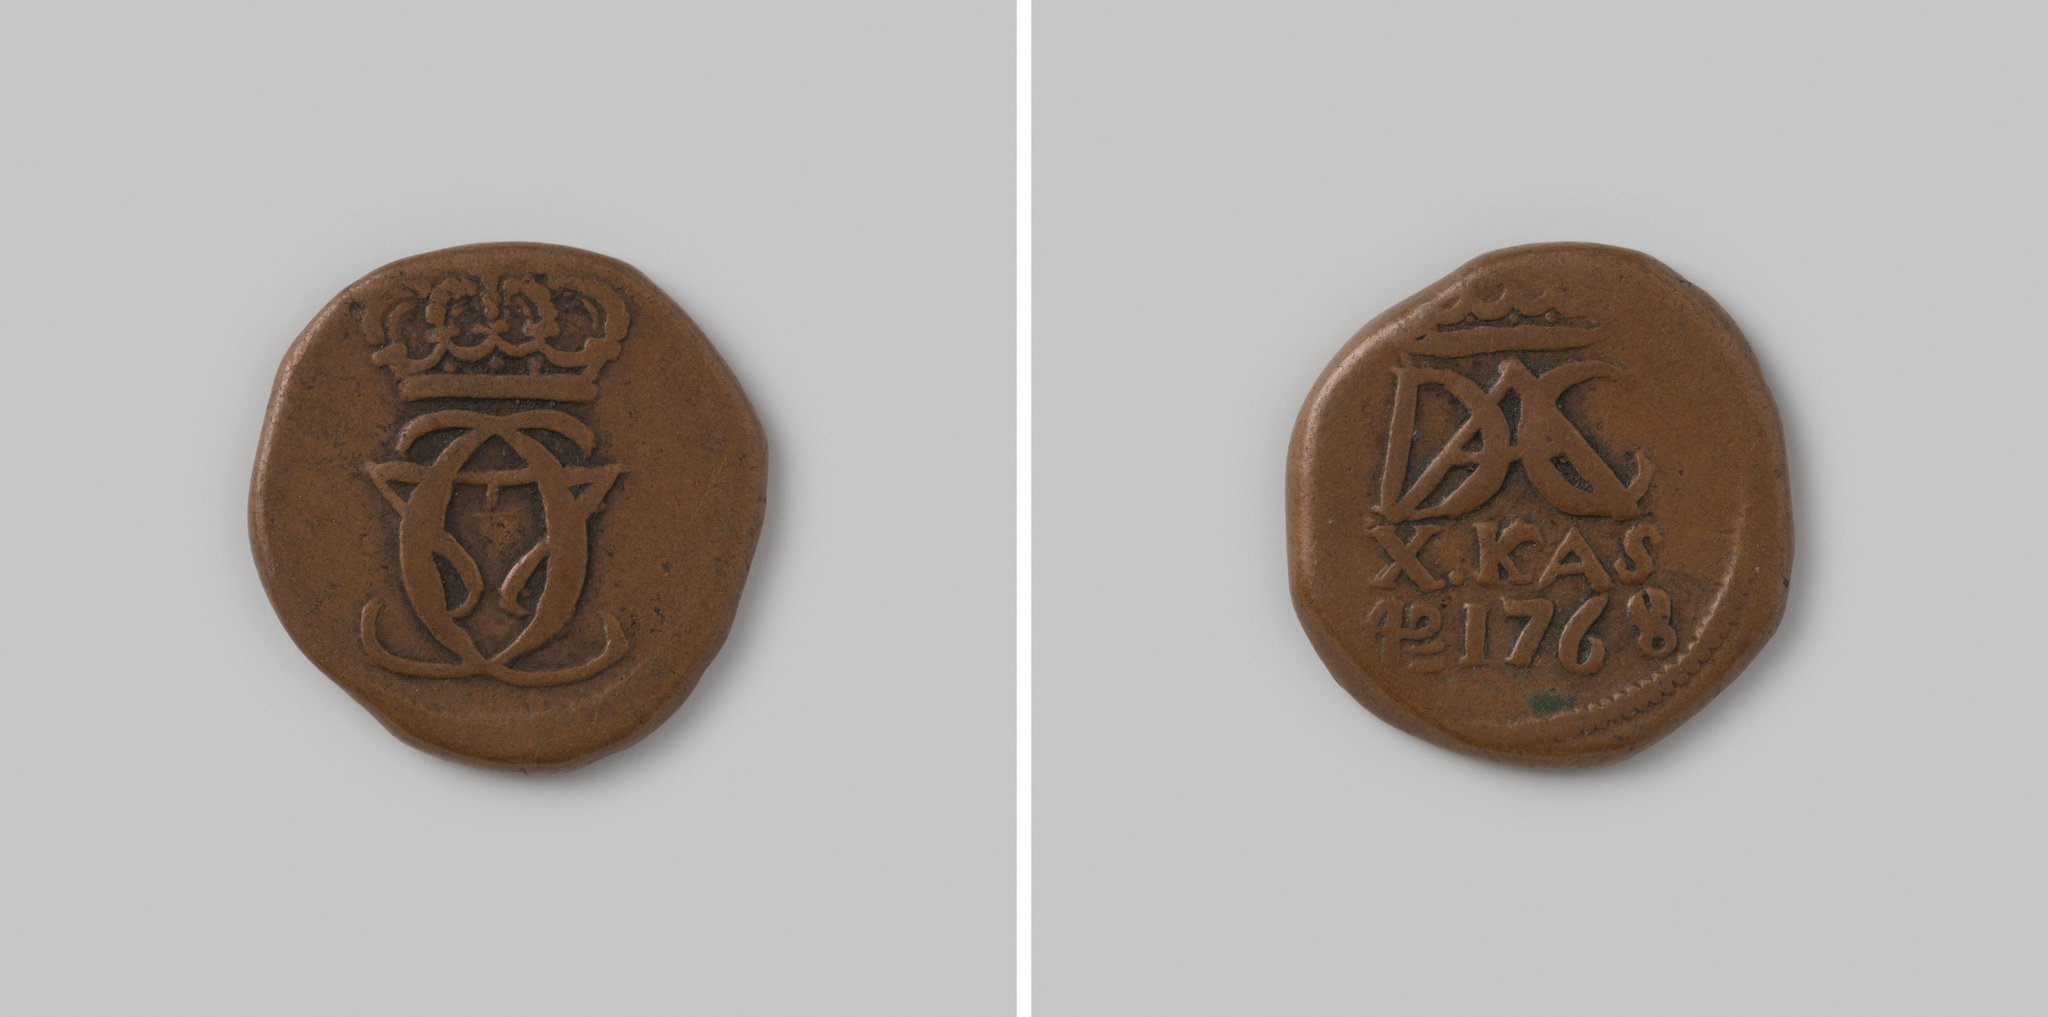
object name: coin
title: Tranquebar, Deens-India, Deense Aziatische Compagnie (DAC) op naam van koning Christiaan VII, 10 kas, 1768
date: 1768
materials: copper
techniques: striking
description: Koperen munt. Voorzijde: gekroond dubbel monogram van de koning. Keerzijde: gekroond monogram van de DAC. Daaronder waarde-aanduiding: X. kas, waaronder jaartal.